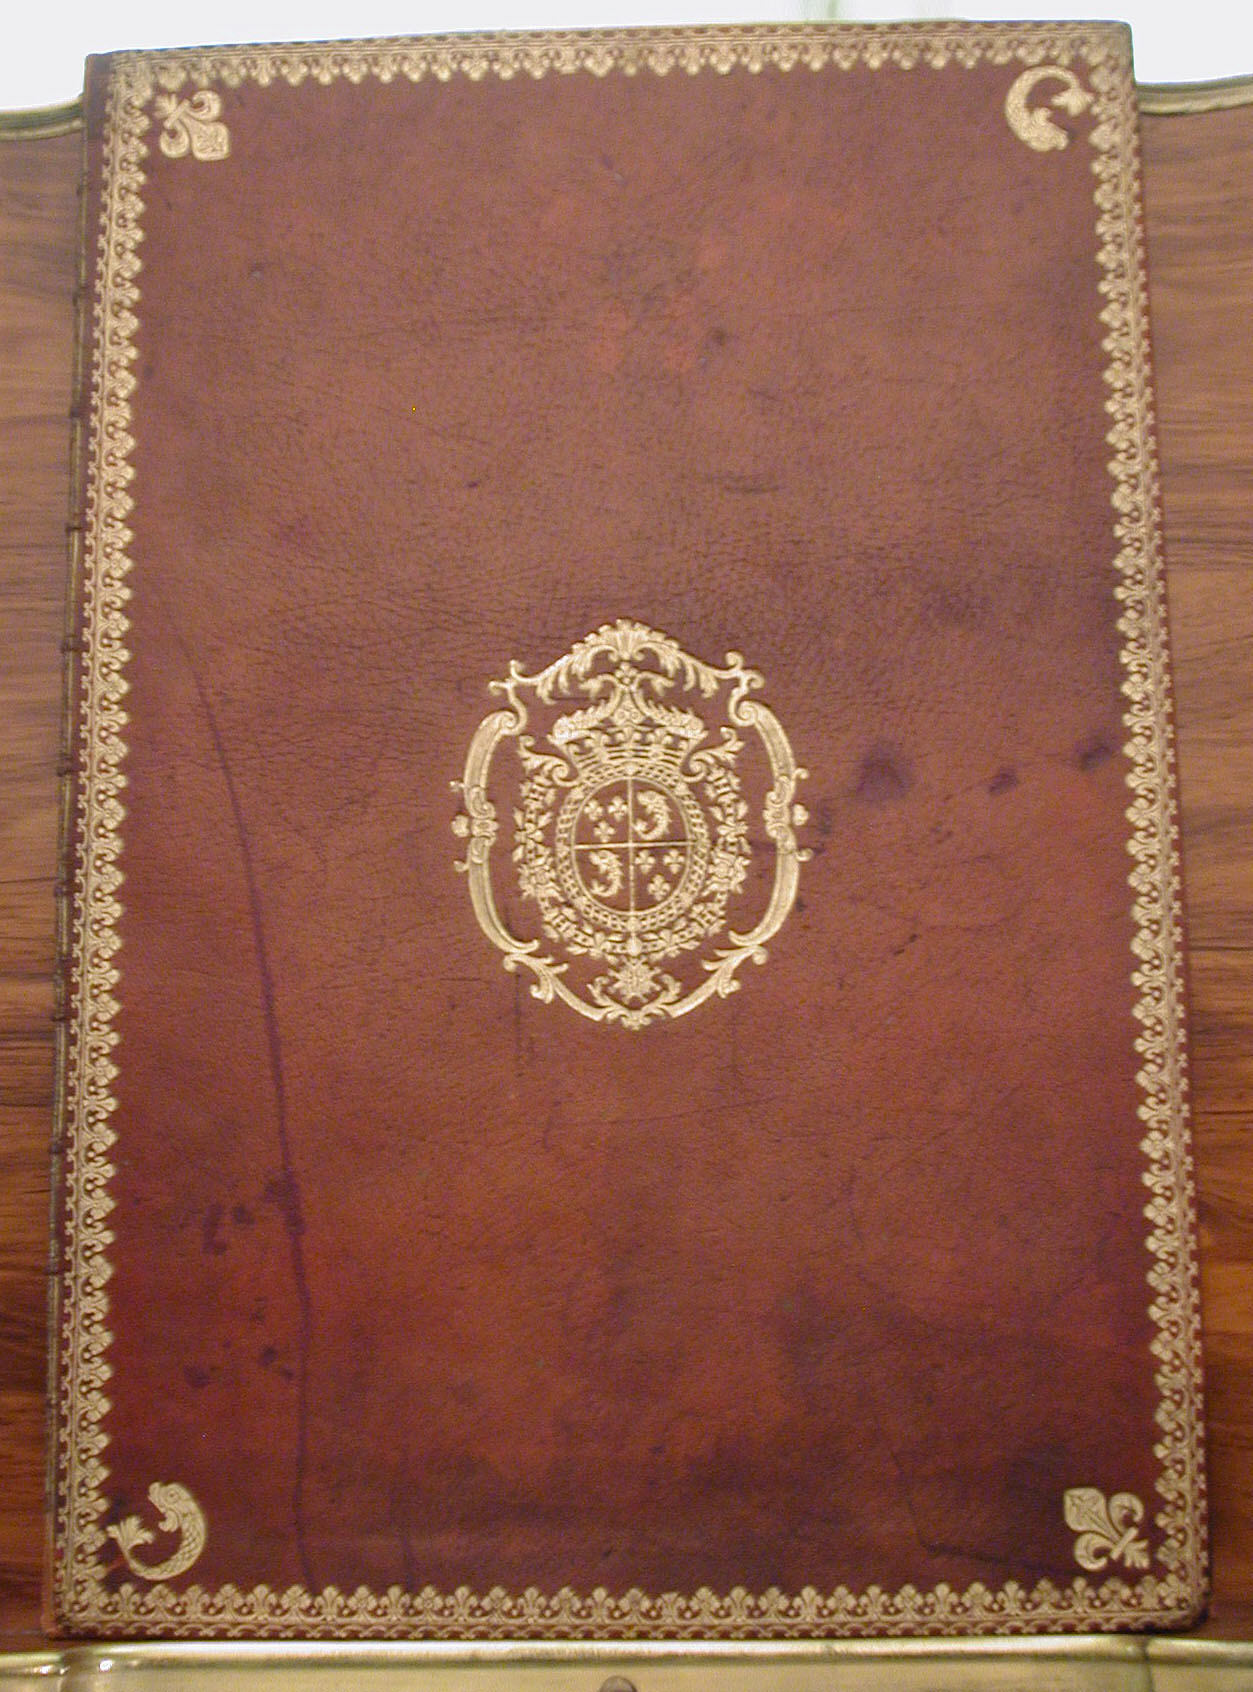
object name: book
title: Nouveau Recueil des Troupes Legeres de France Levees depuis la presente Guerre, avec la date de leur creation, le nombre dont chaque Corps est compose; leur Uniforme & leurs Armes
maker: p. b. la rüe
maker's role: illustrator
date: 1747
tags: coat of arms